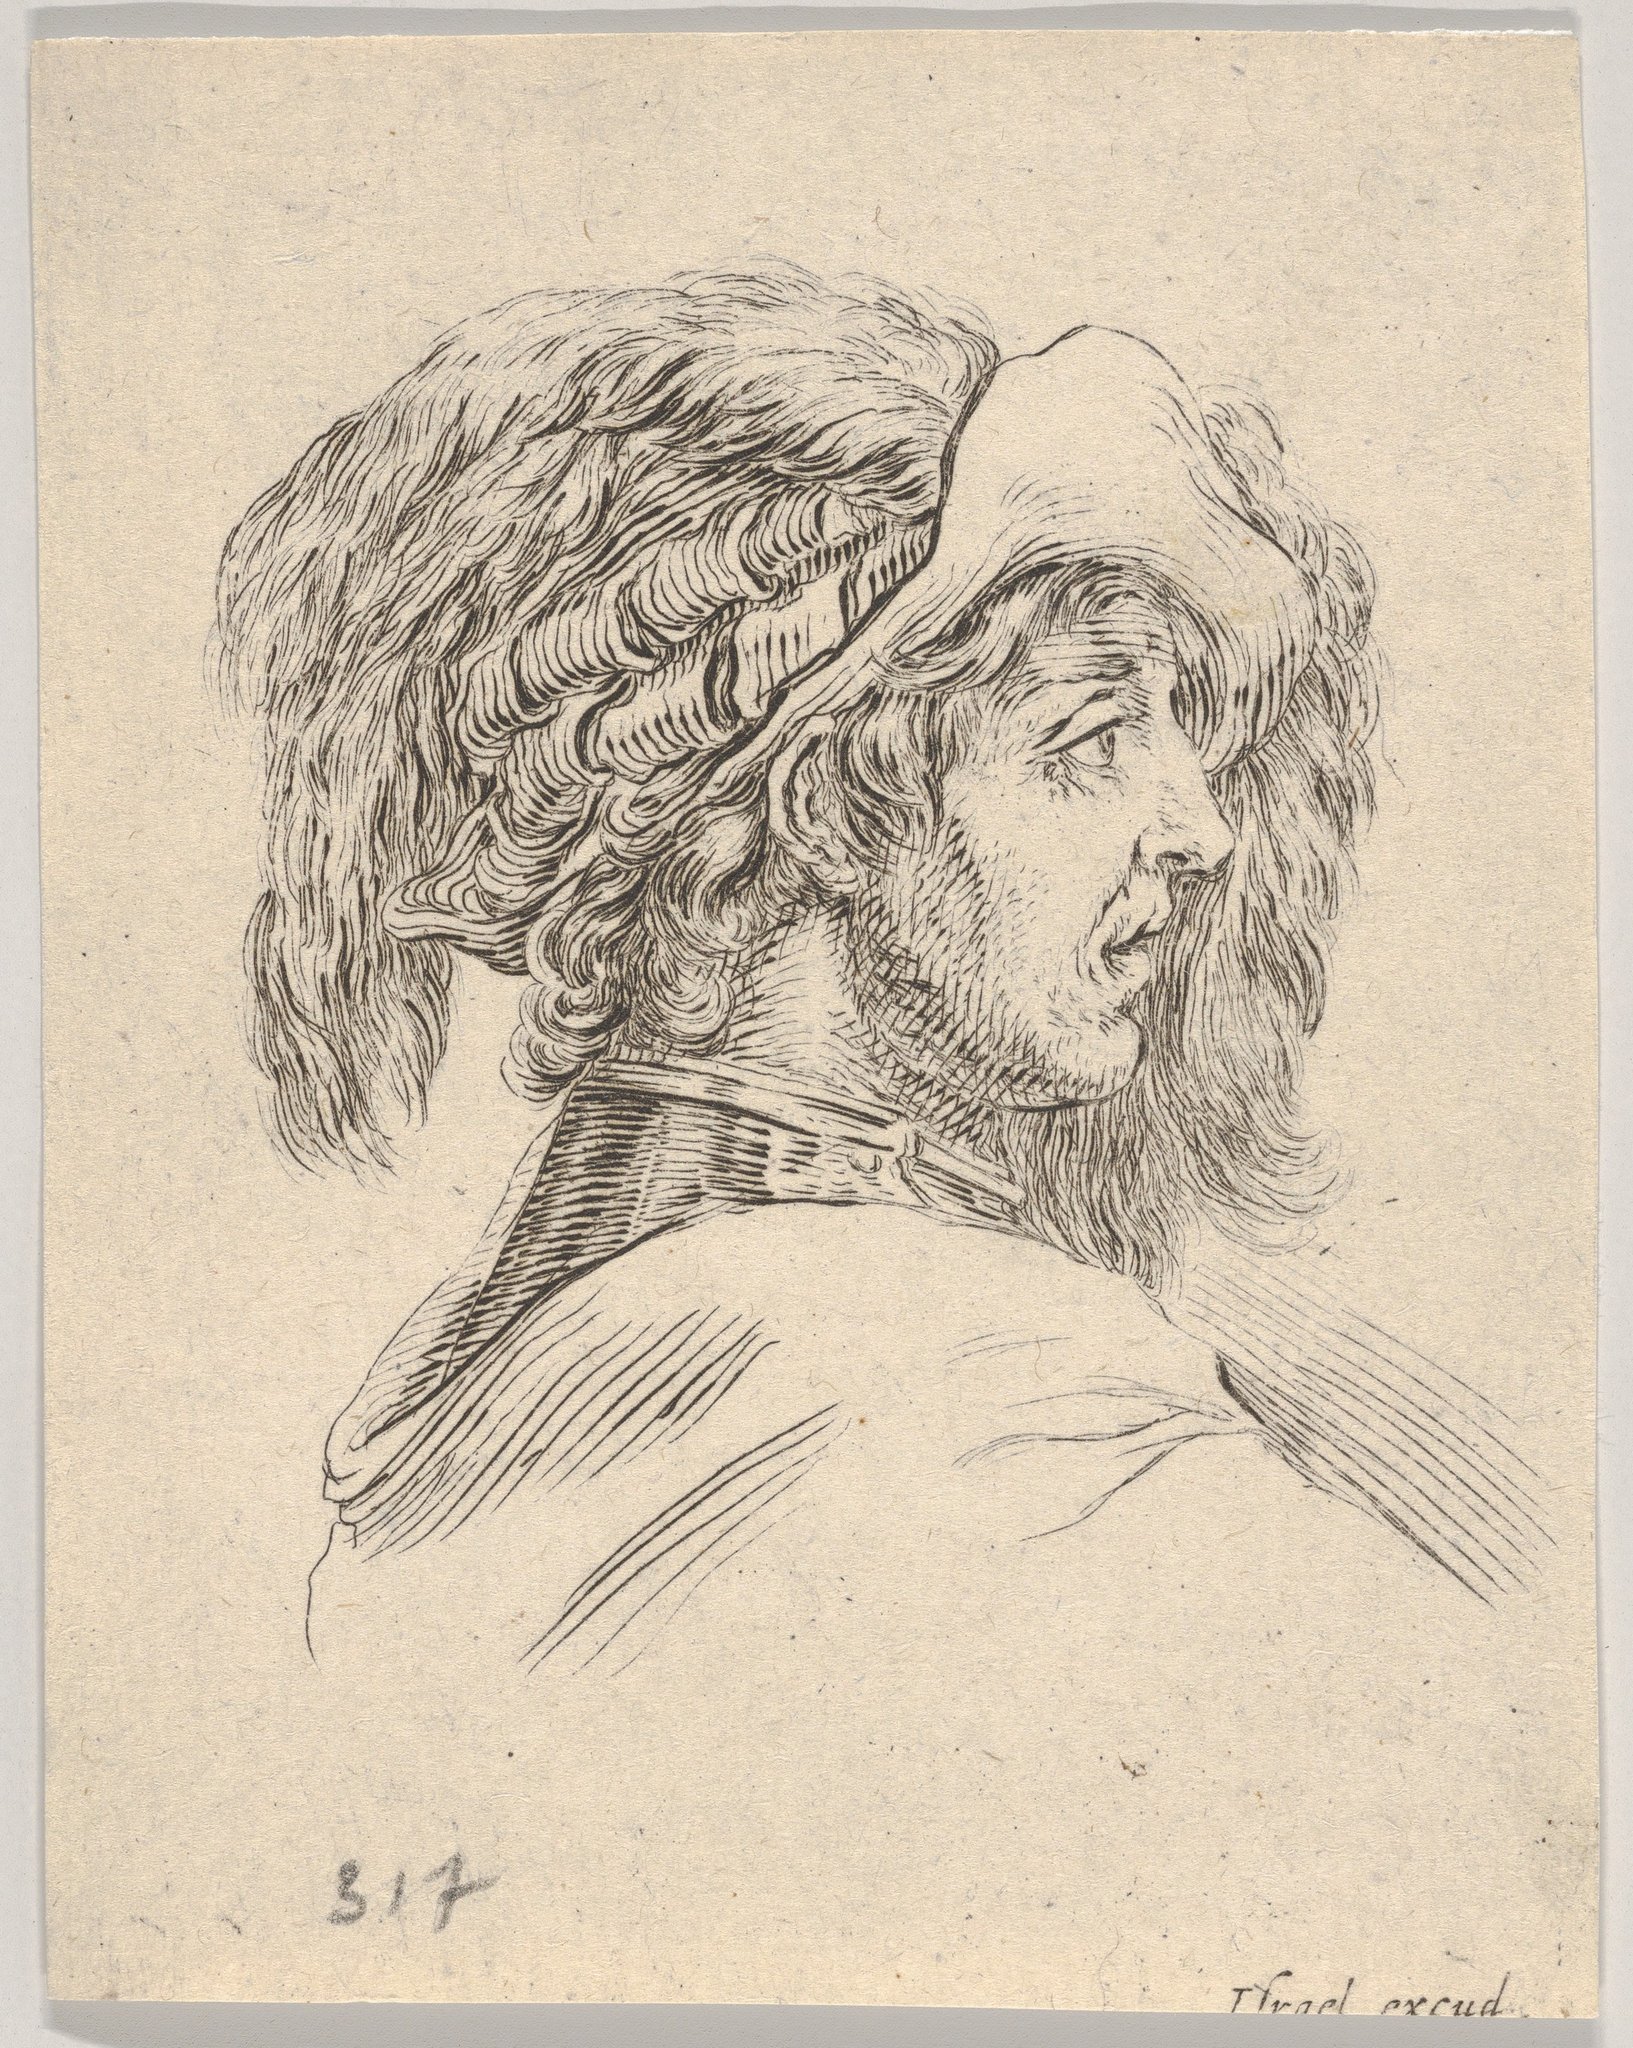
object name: print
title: Plate 10: Head of a Man without a Beard, Turned in Profile to the Right, from "Various heads and figures" (Diverses têtes et figures)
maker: stefano della bella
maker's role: artist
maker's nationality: italian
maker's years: 1610-1664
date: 1650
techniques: etching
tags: men,profiles